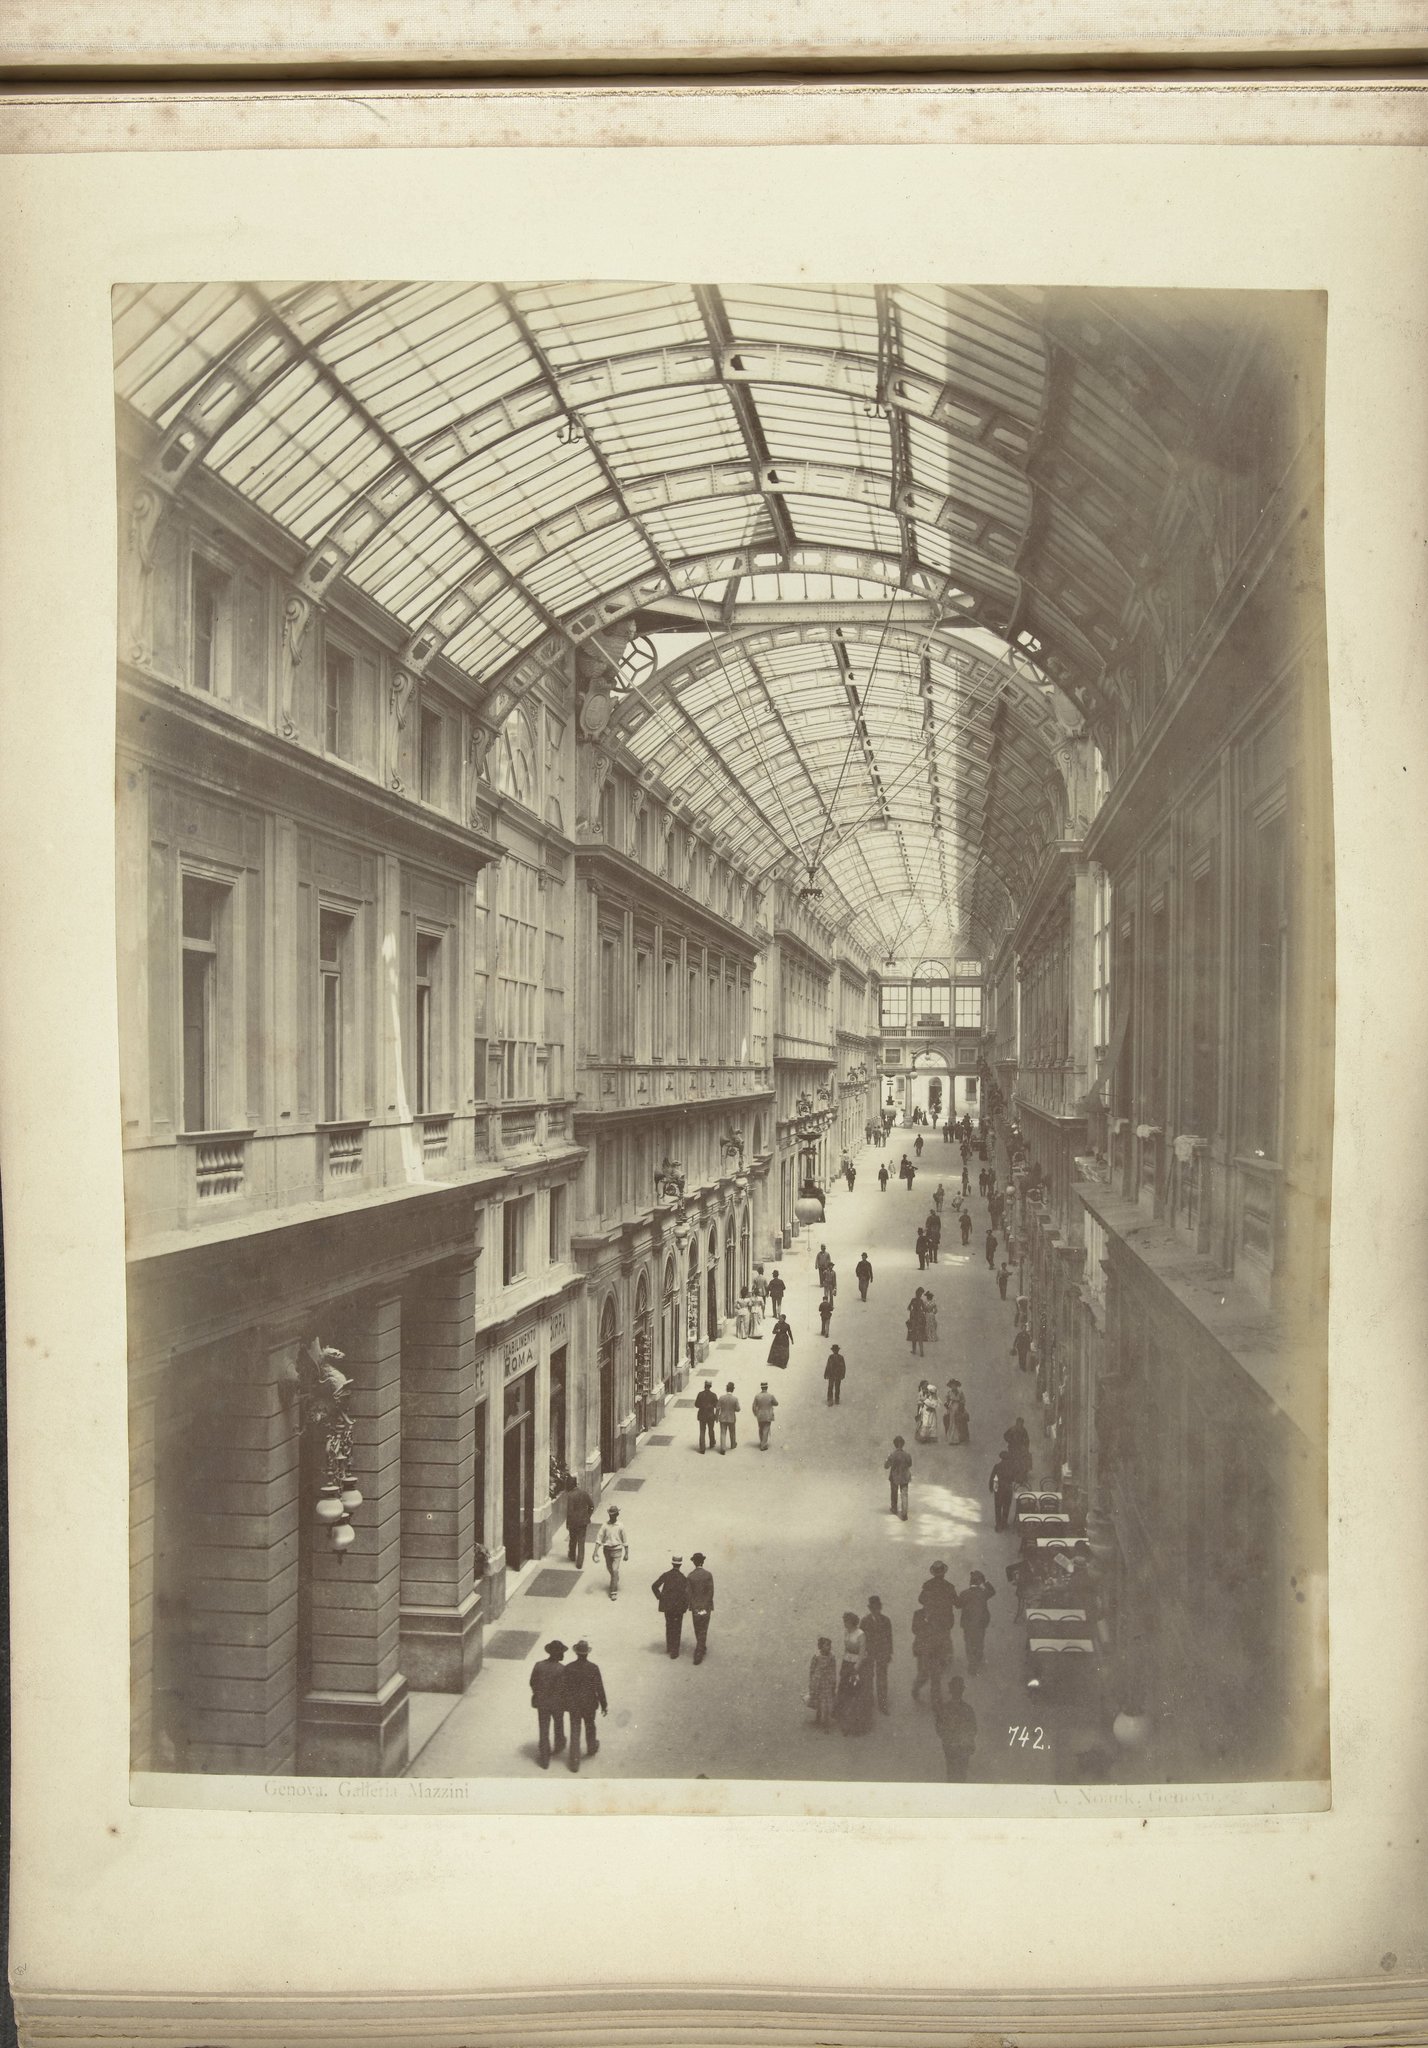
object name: album leaf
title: Genova. Galleria Mazzini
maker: alfredo noack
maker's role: fotograaf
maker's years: 1833-1895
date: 1880-1893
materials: paper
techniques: albumen print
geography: genoa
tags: gallery (spacious corridor)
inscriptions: number: ‘742.’